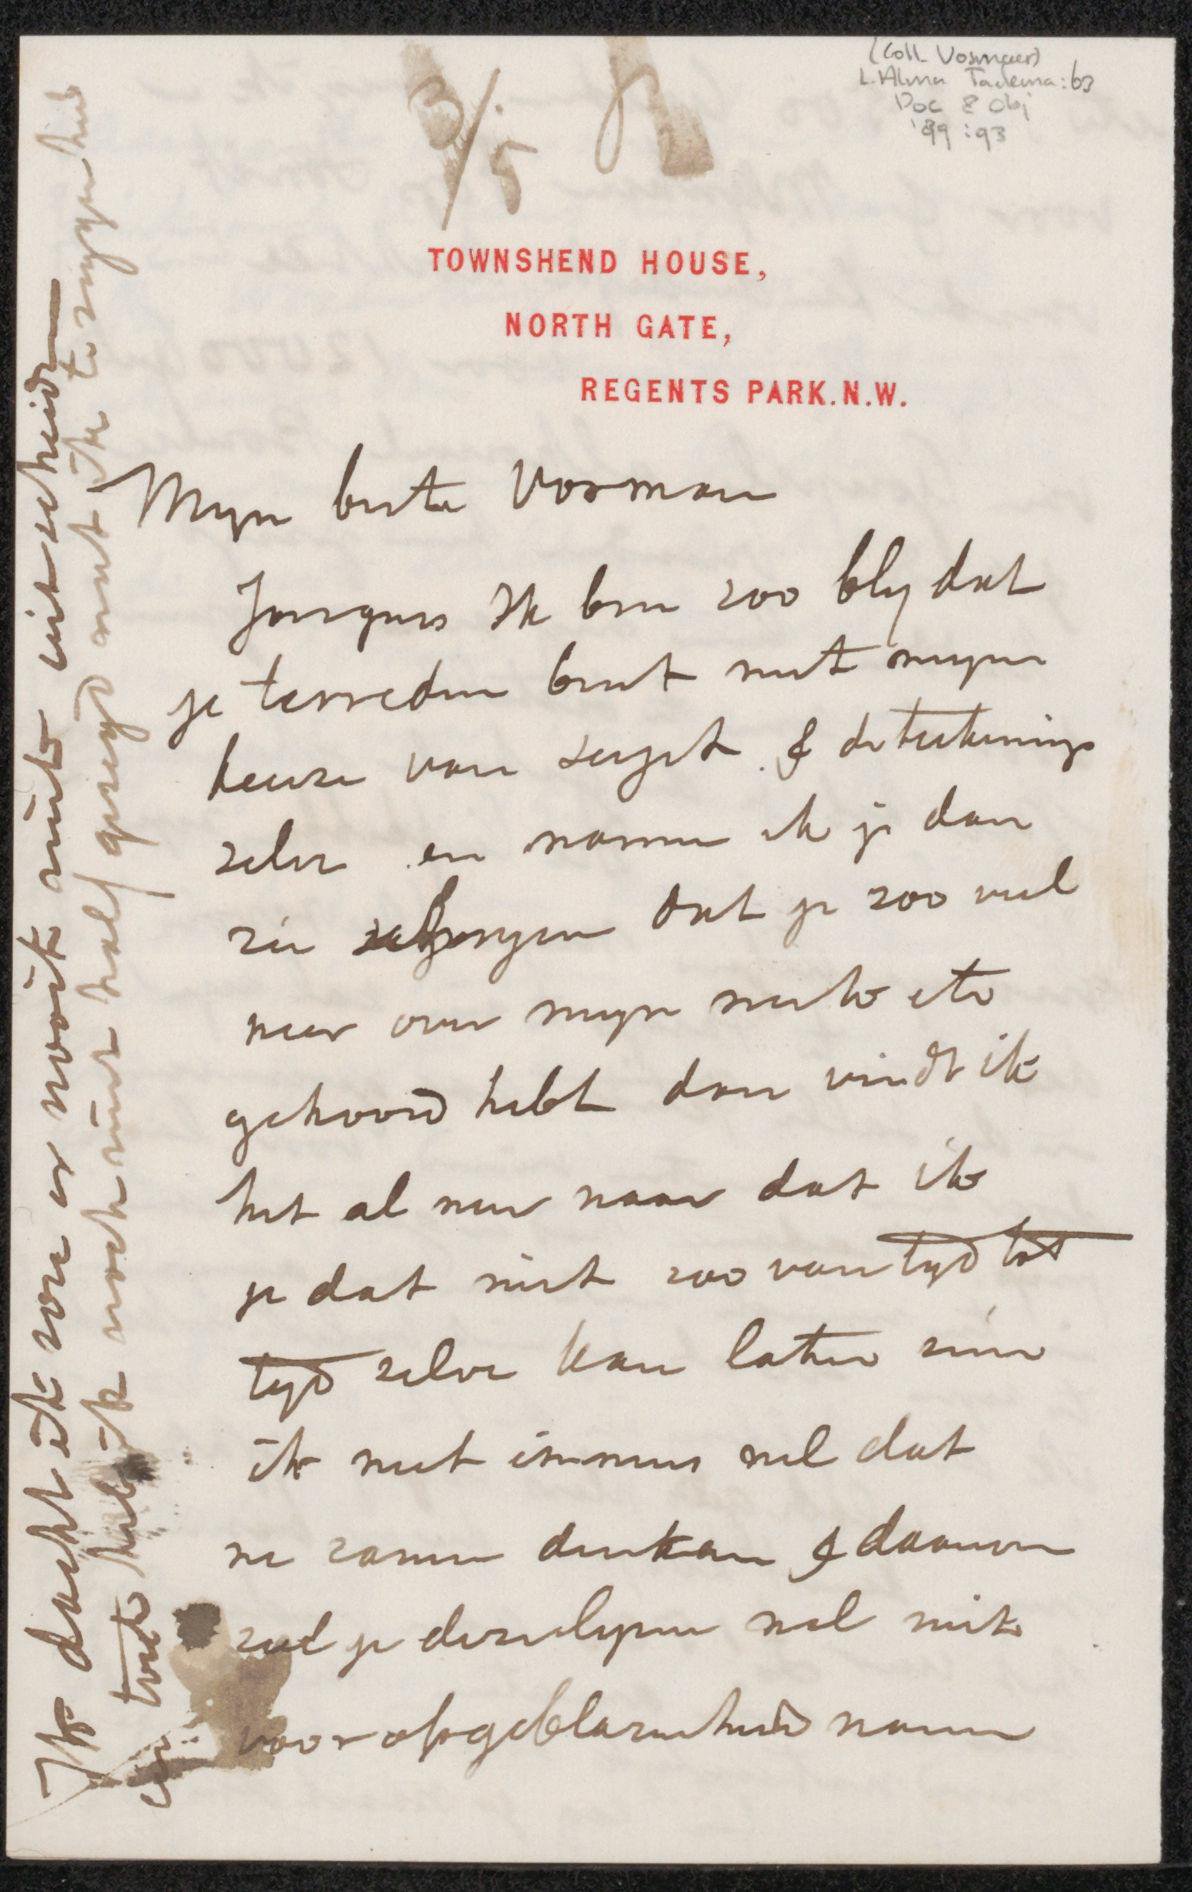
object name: letter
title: Brief aan Carel Vosmaer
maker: lourens alma tadema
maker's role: draughtsman, print maker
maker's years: 1836-1912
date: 1882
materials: ink, paper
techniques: pen, printing, writing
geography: london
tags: amsterdam, carel vosmaer, printer, publisher, art trade, art shop, drawing, painting (including book-illumination, miniature-painting), money, brussels, paris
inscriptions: watermark